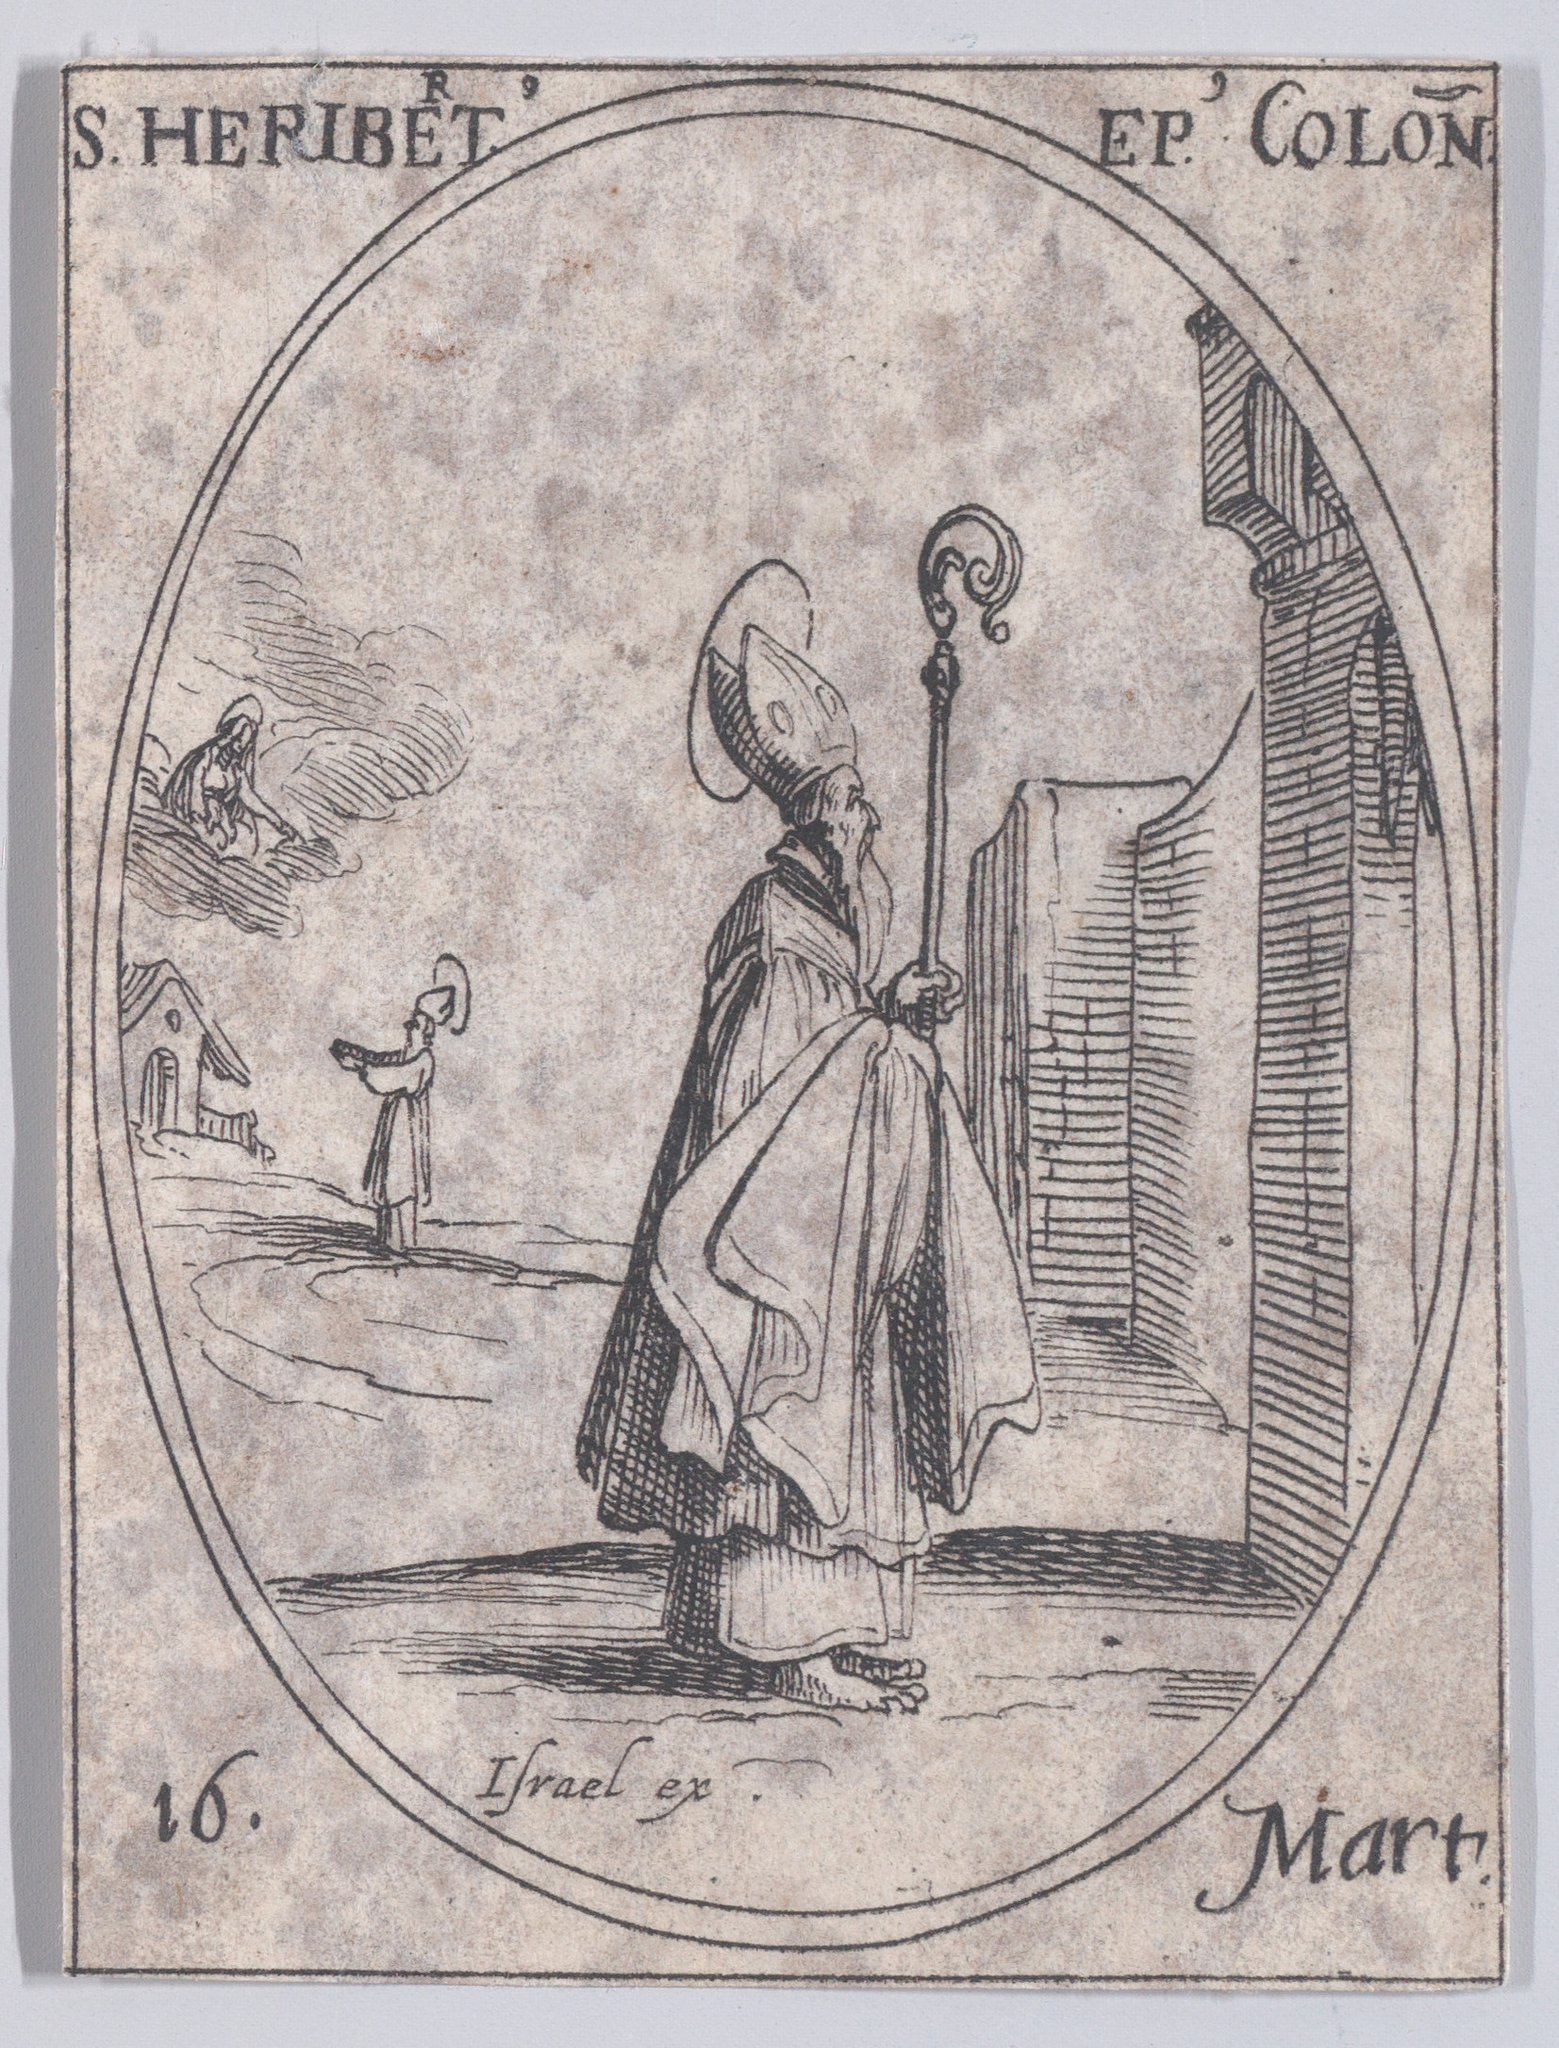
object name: print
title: S. Héribert, évêque de Cologne (St. Heribert, Bishop of Cologne), March 16th, from "Les Images De Tous Les Saincts et Saintes de L'Année" (Images of All of the Saints and Religious Events of the Year)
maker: jacques callot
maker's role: artist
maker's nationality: french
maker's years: 1592-1635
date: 1636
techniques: etching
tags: men,saints